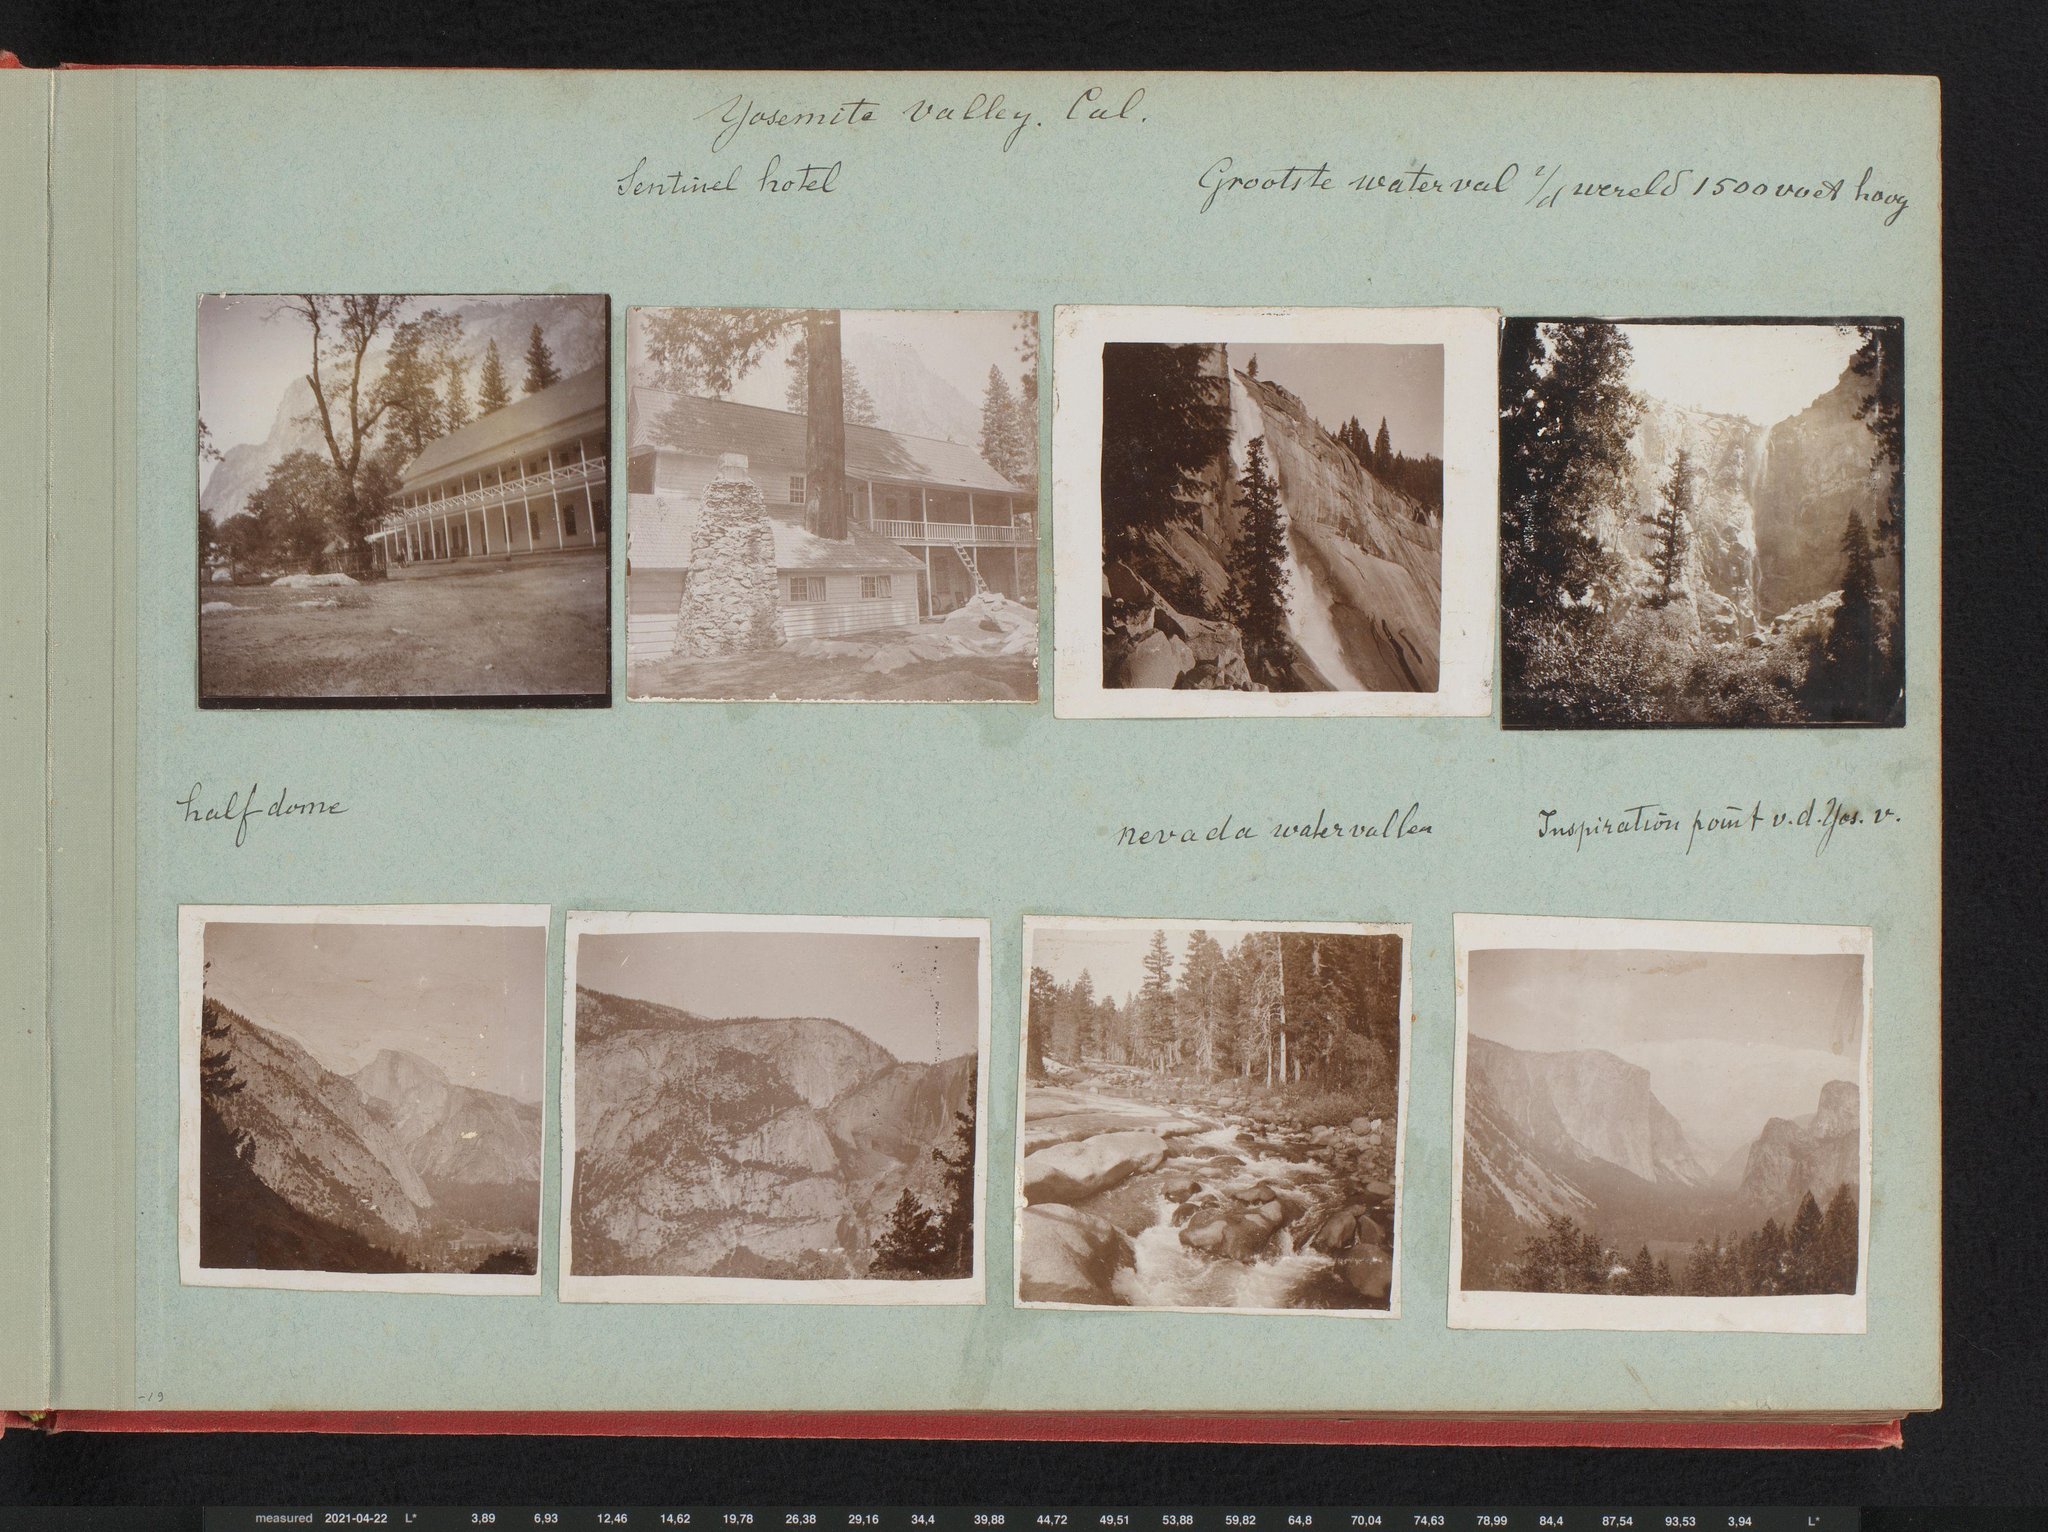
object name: photograph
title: Yosemite valley, Cal.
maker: Anonymous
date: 1898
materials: paper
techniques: collodion silver print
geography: yosemite valley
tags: rapids, waterfall, forest, wood, hotel, hostelry, inn, mountains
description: Deze foto's zijn onderdeel van een album.